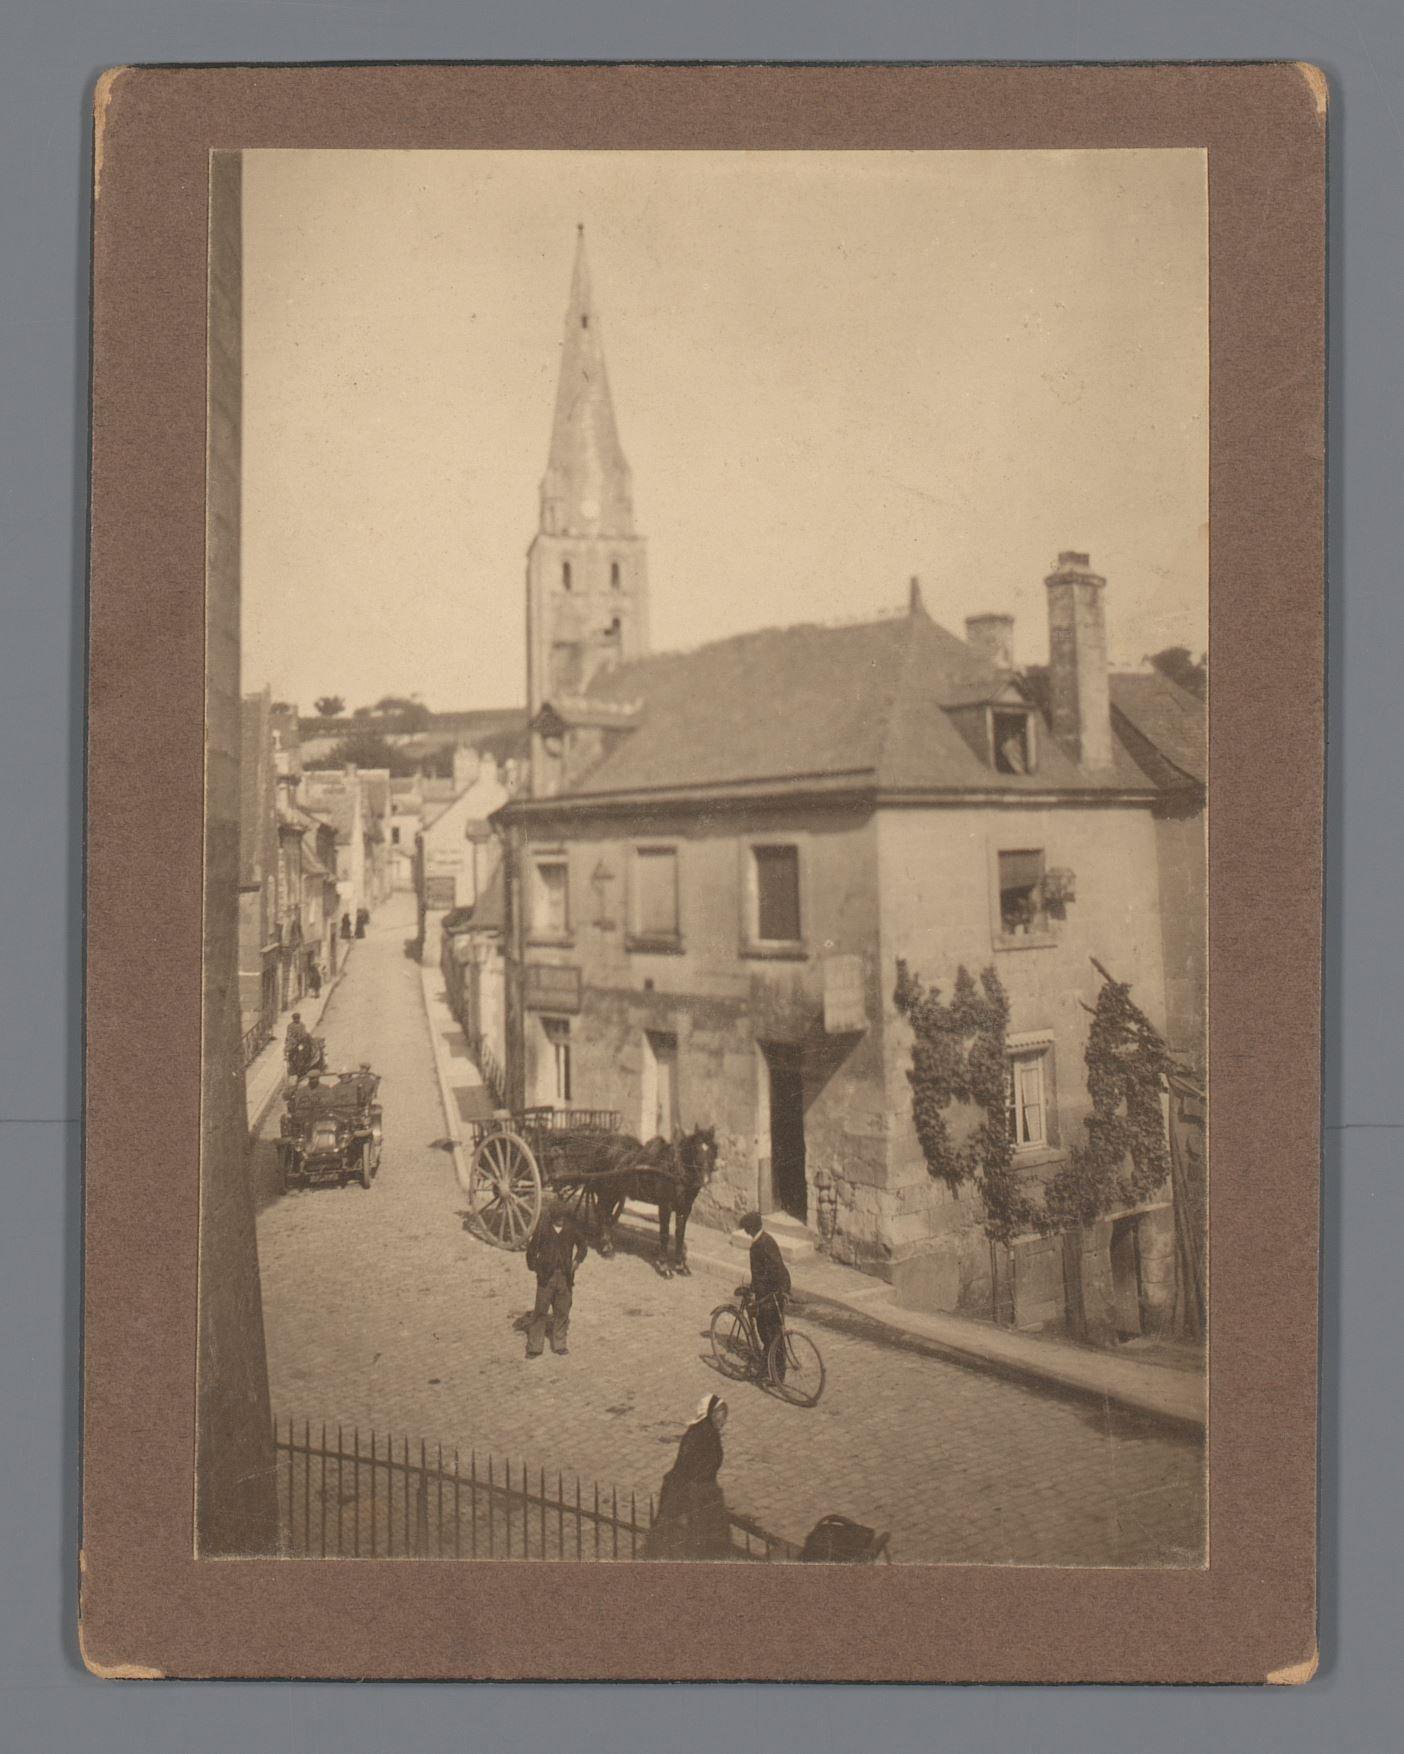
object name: photograph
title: Gezicht op een Belgische (?) stad of dorp, met een kerk, huizen, en op straat een auto, naast een koets en fietser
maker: Anonymous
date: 1880-1910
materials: cardboard, paper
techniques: gelatin silver print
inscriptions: number: ‘22’, annotation: ‘18 sept 10 1/2 uur’, annotation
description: Gezicht op een Belgische (?) stad of dorp, met een kerk, huizen, en op straat een auto, naast een koets en fietser.